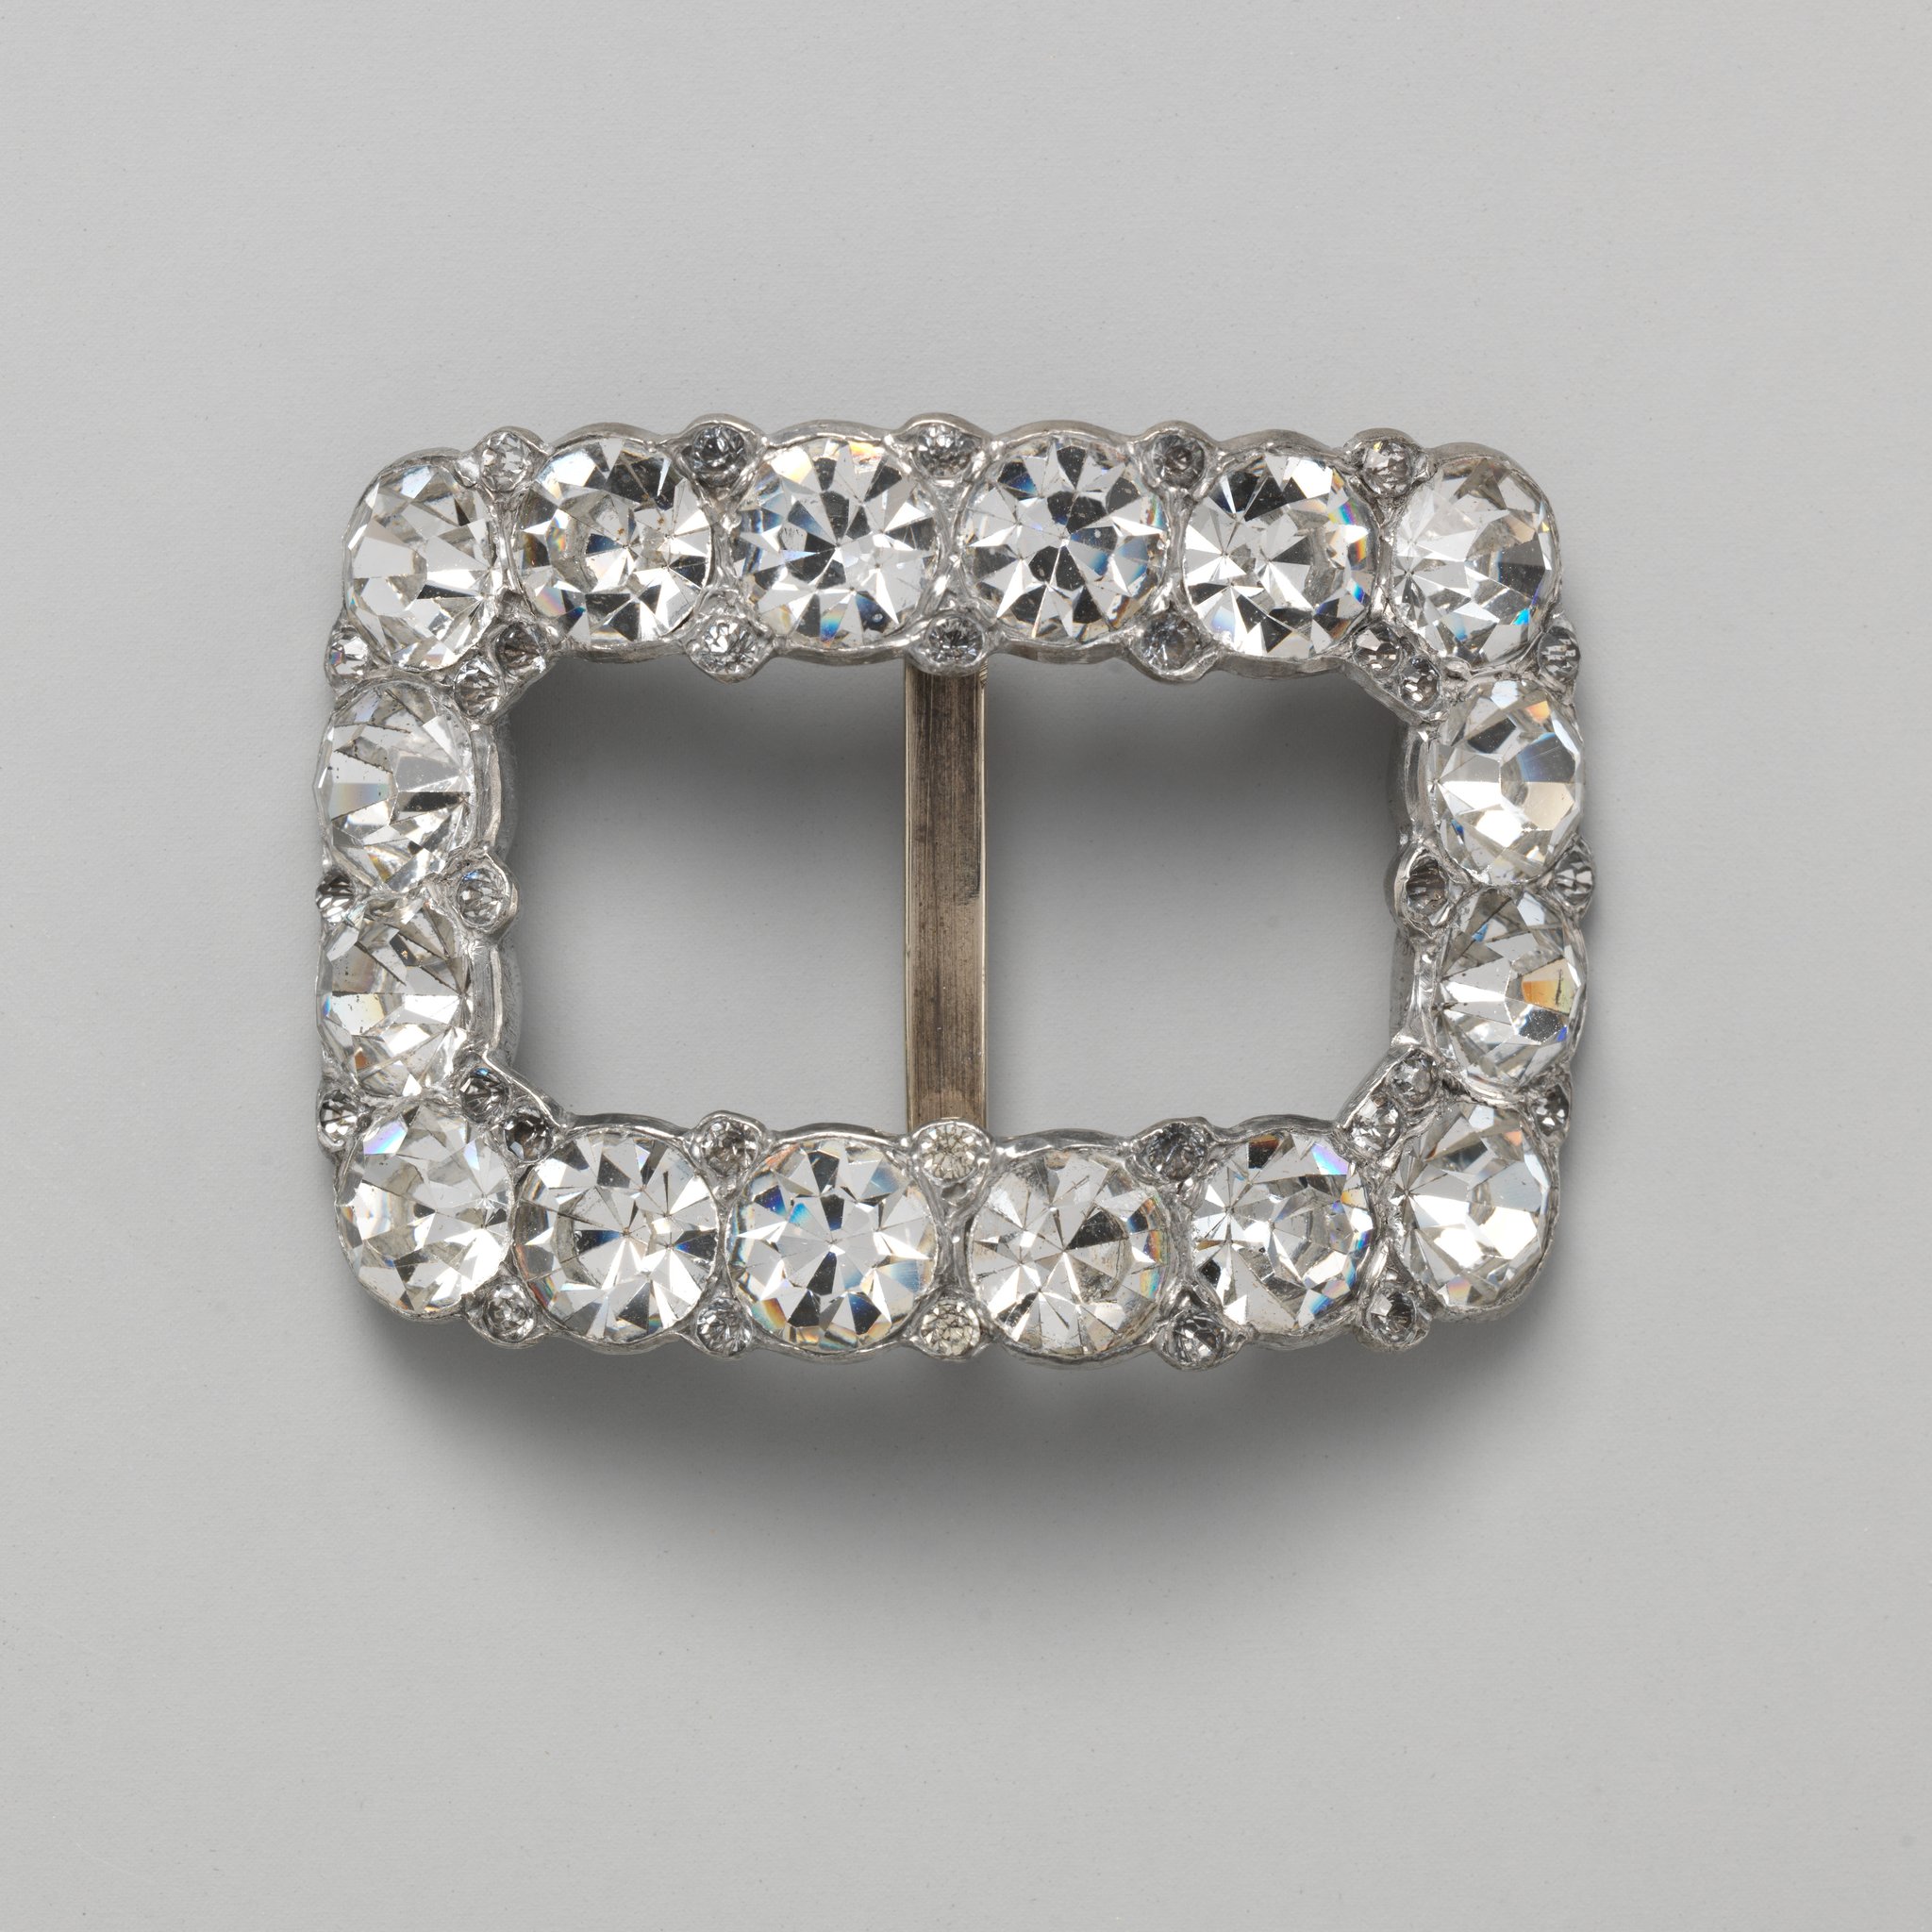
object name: shoe buckle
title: Shoe buckles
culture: british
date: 1701-1800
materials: metal